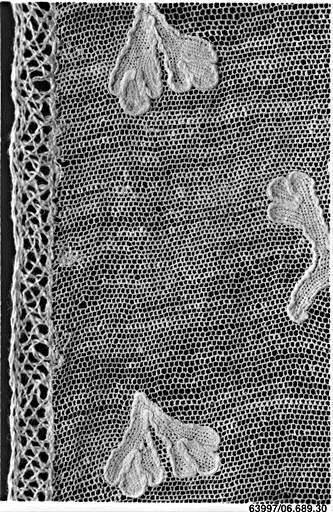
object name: fragment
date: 1800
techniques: lace